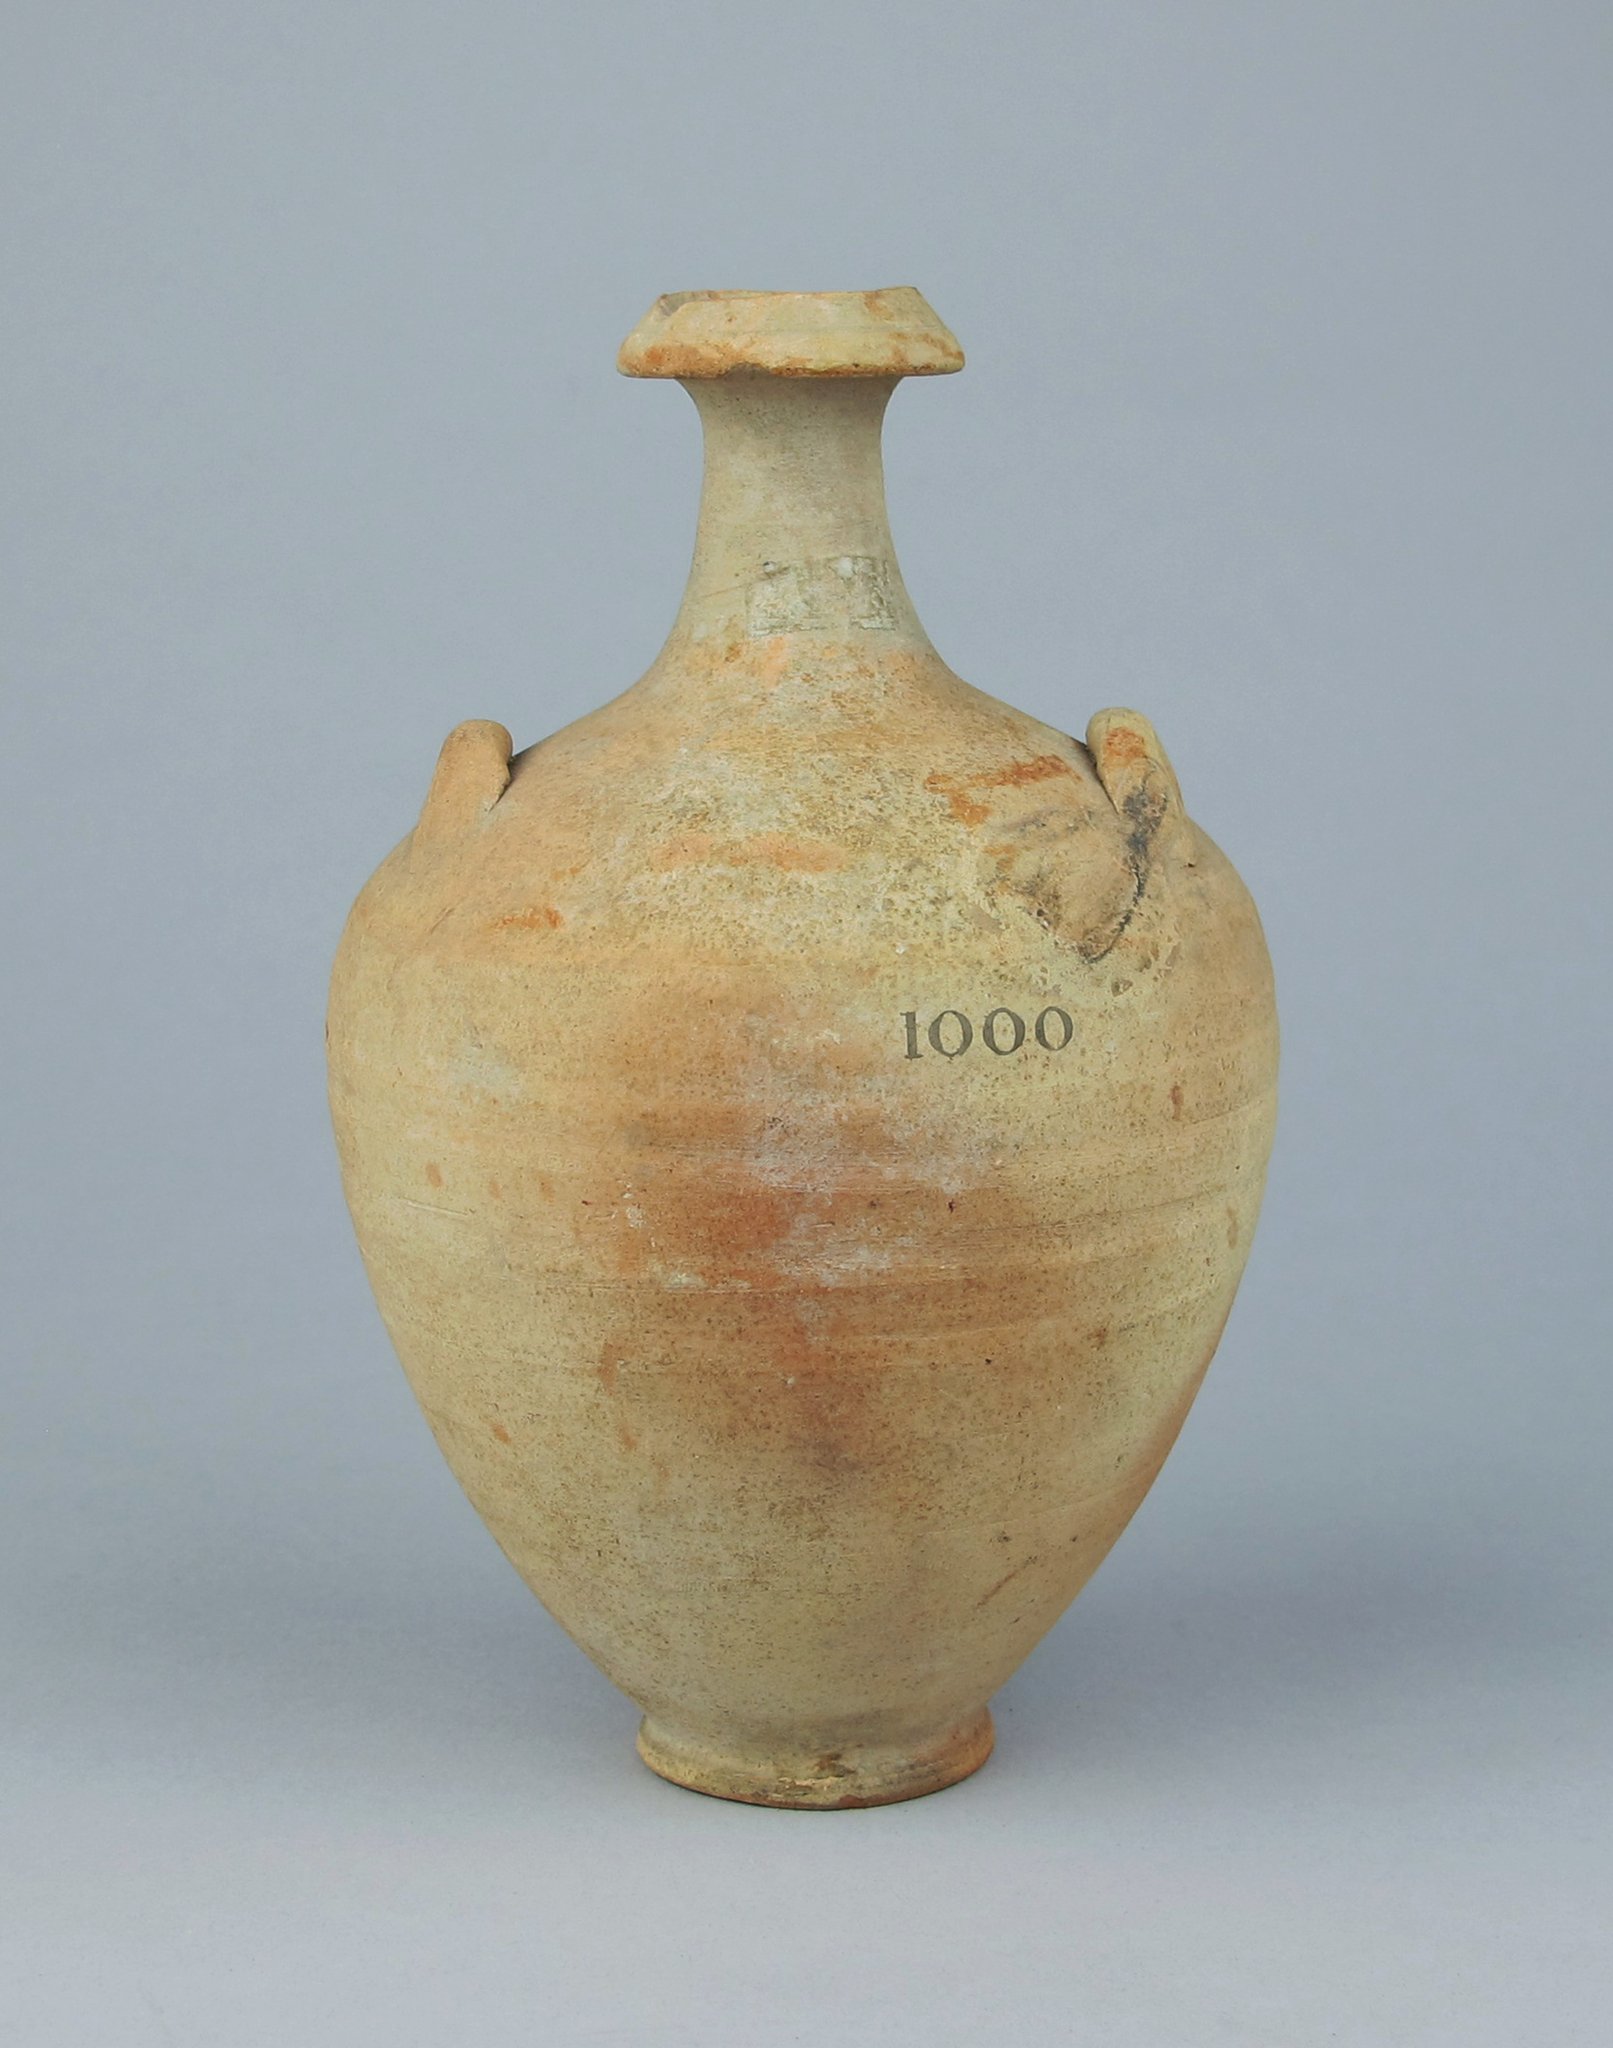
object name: juglet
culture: cypriot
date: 480-400 BCE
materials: terracotta